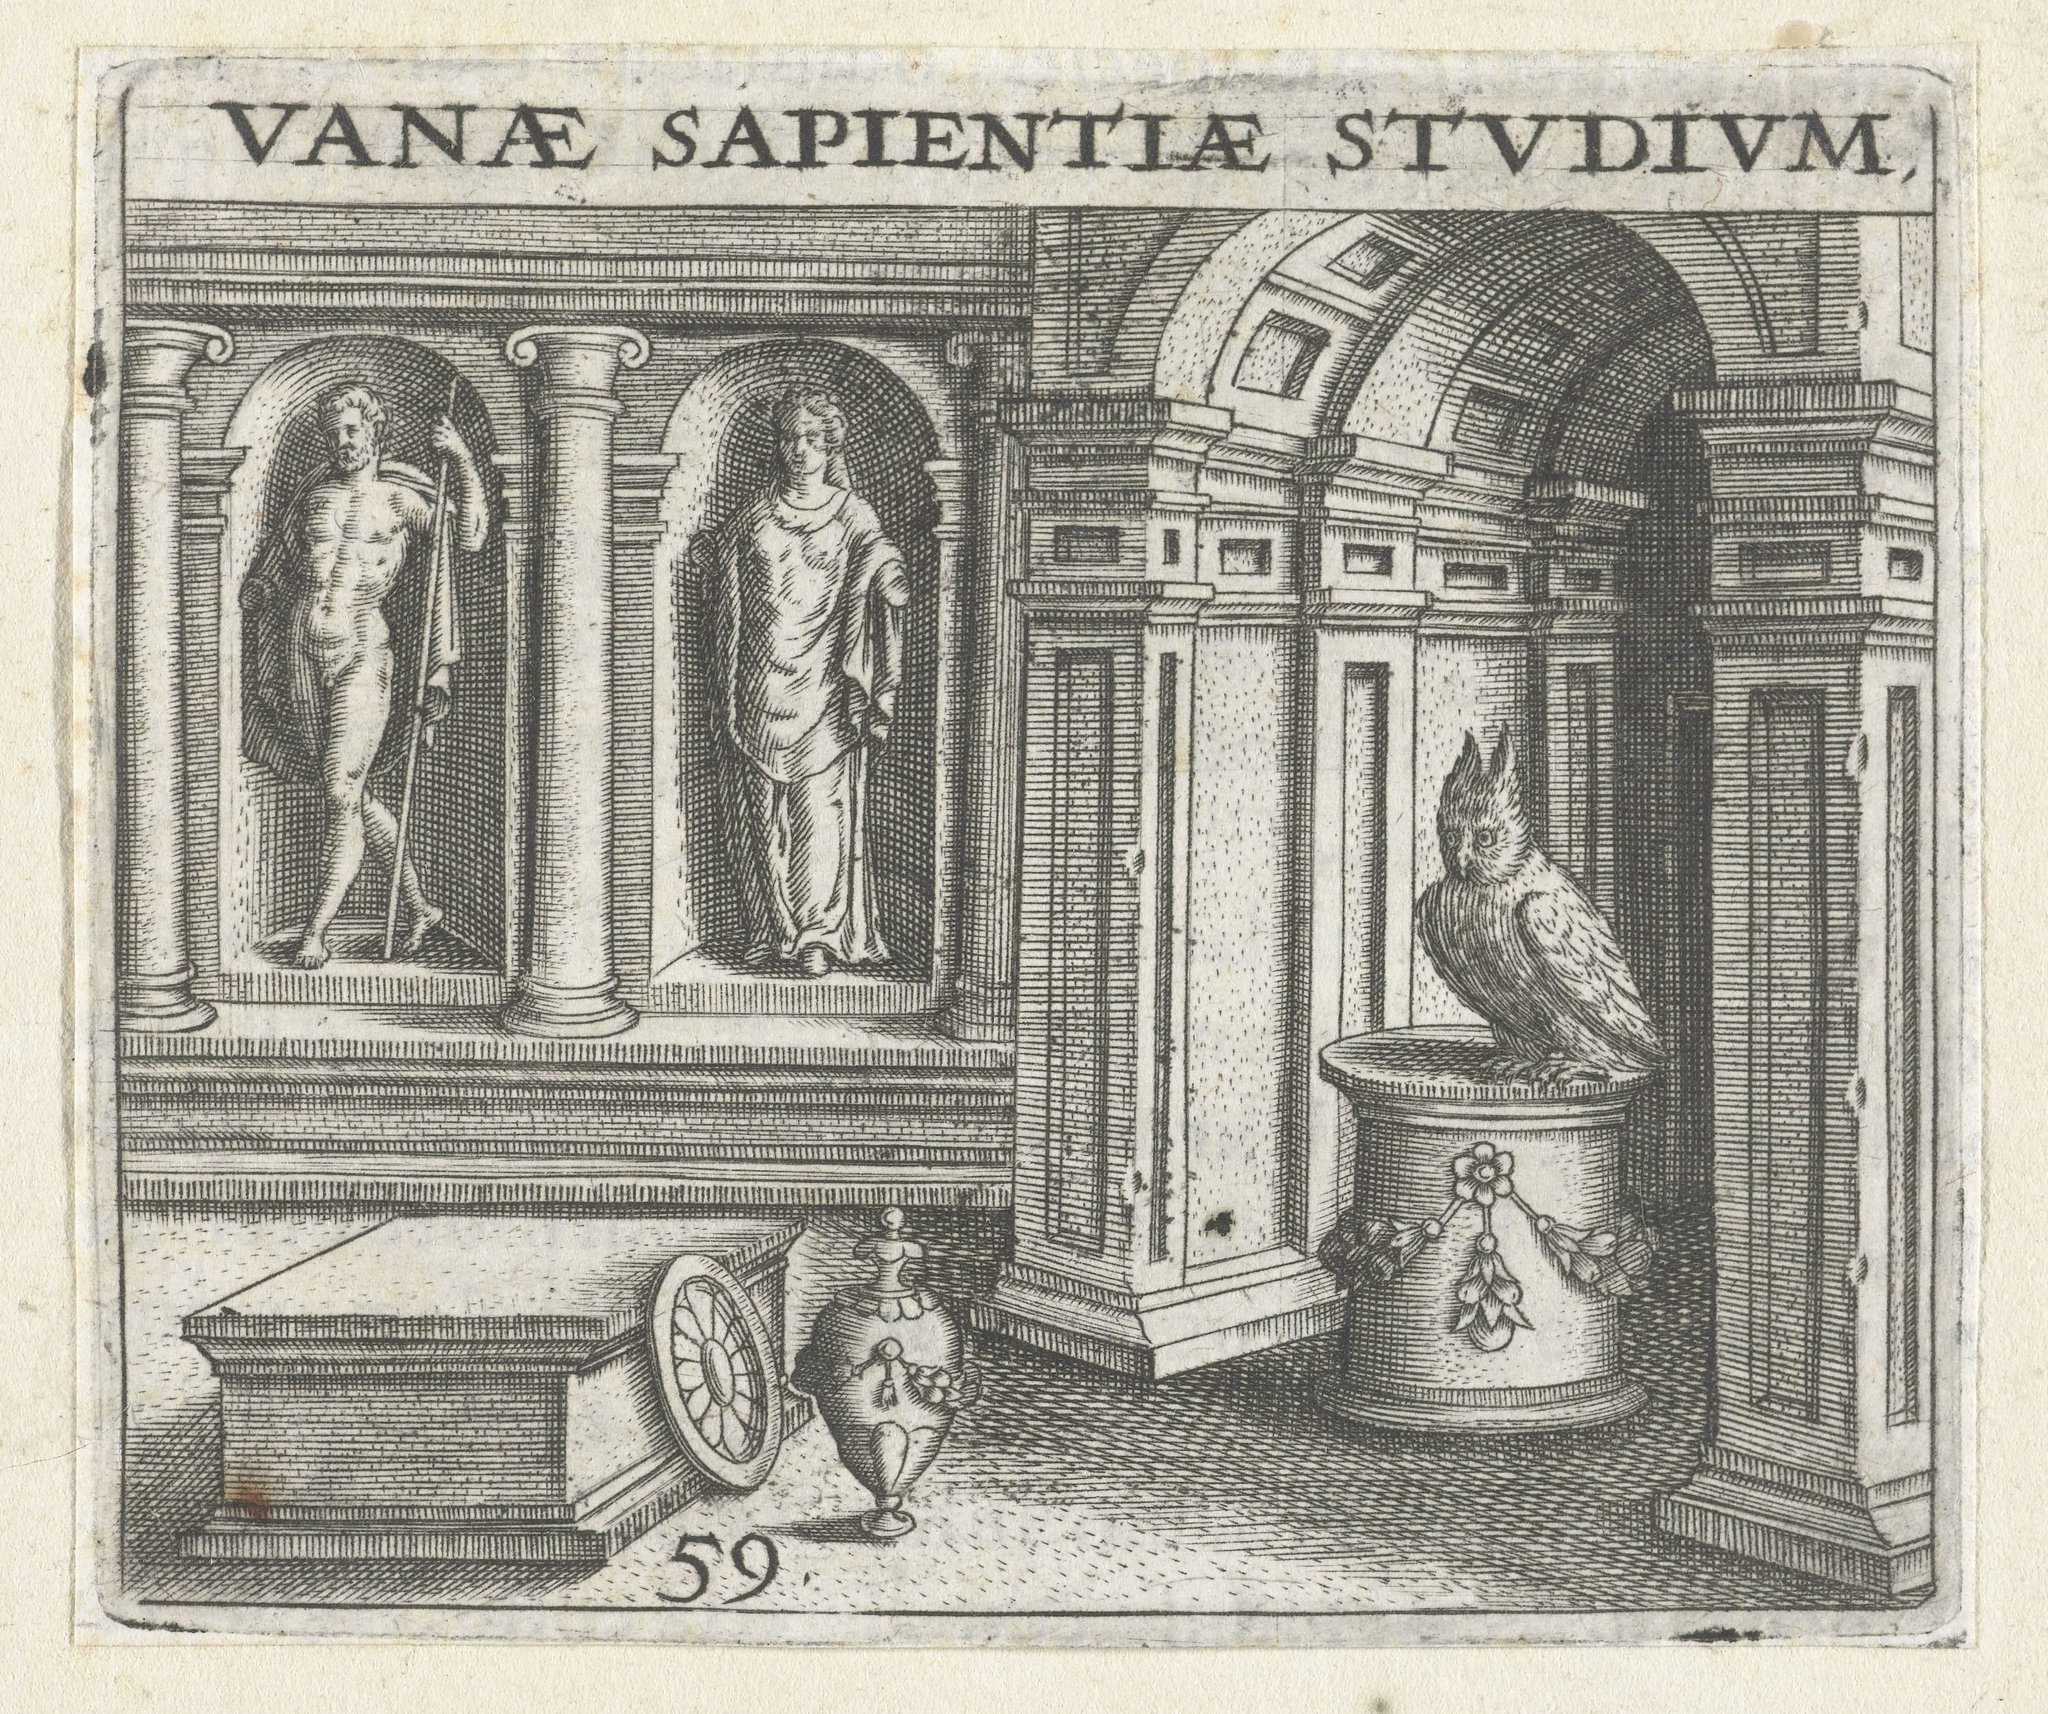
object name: book illustration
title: VANAE SAPIENTIAE STVDIVM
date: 1596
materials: paper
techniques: engraving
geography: frankfurt am main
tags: owls, attributes of minerva: owl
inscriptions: collector's mark: Lugt 240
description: Een uil zit op een rond bodes in een studeervertrek. In de muur staan twee beelden in nissen en op de grond staat een schild en een vaas.